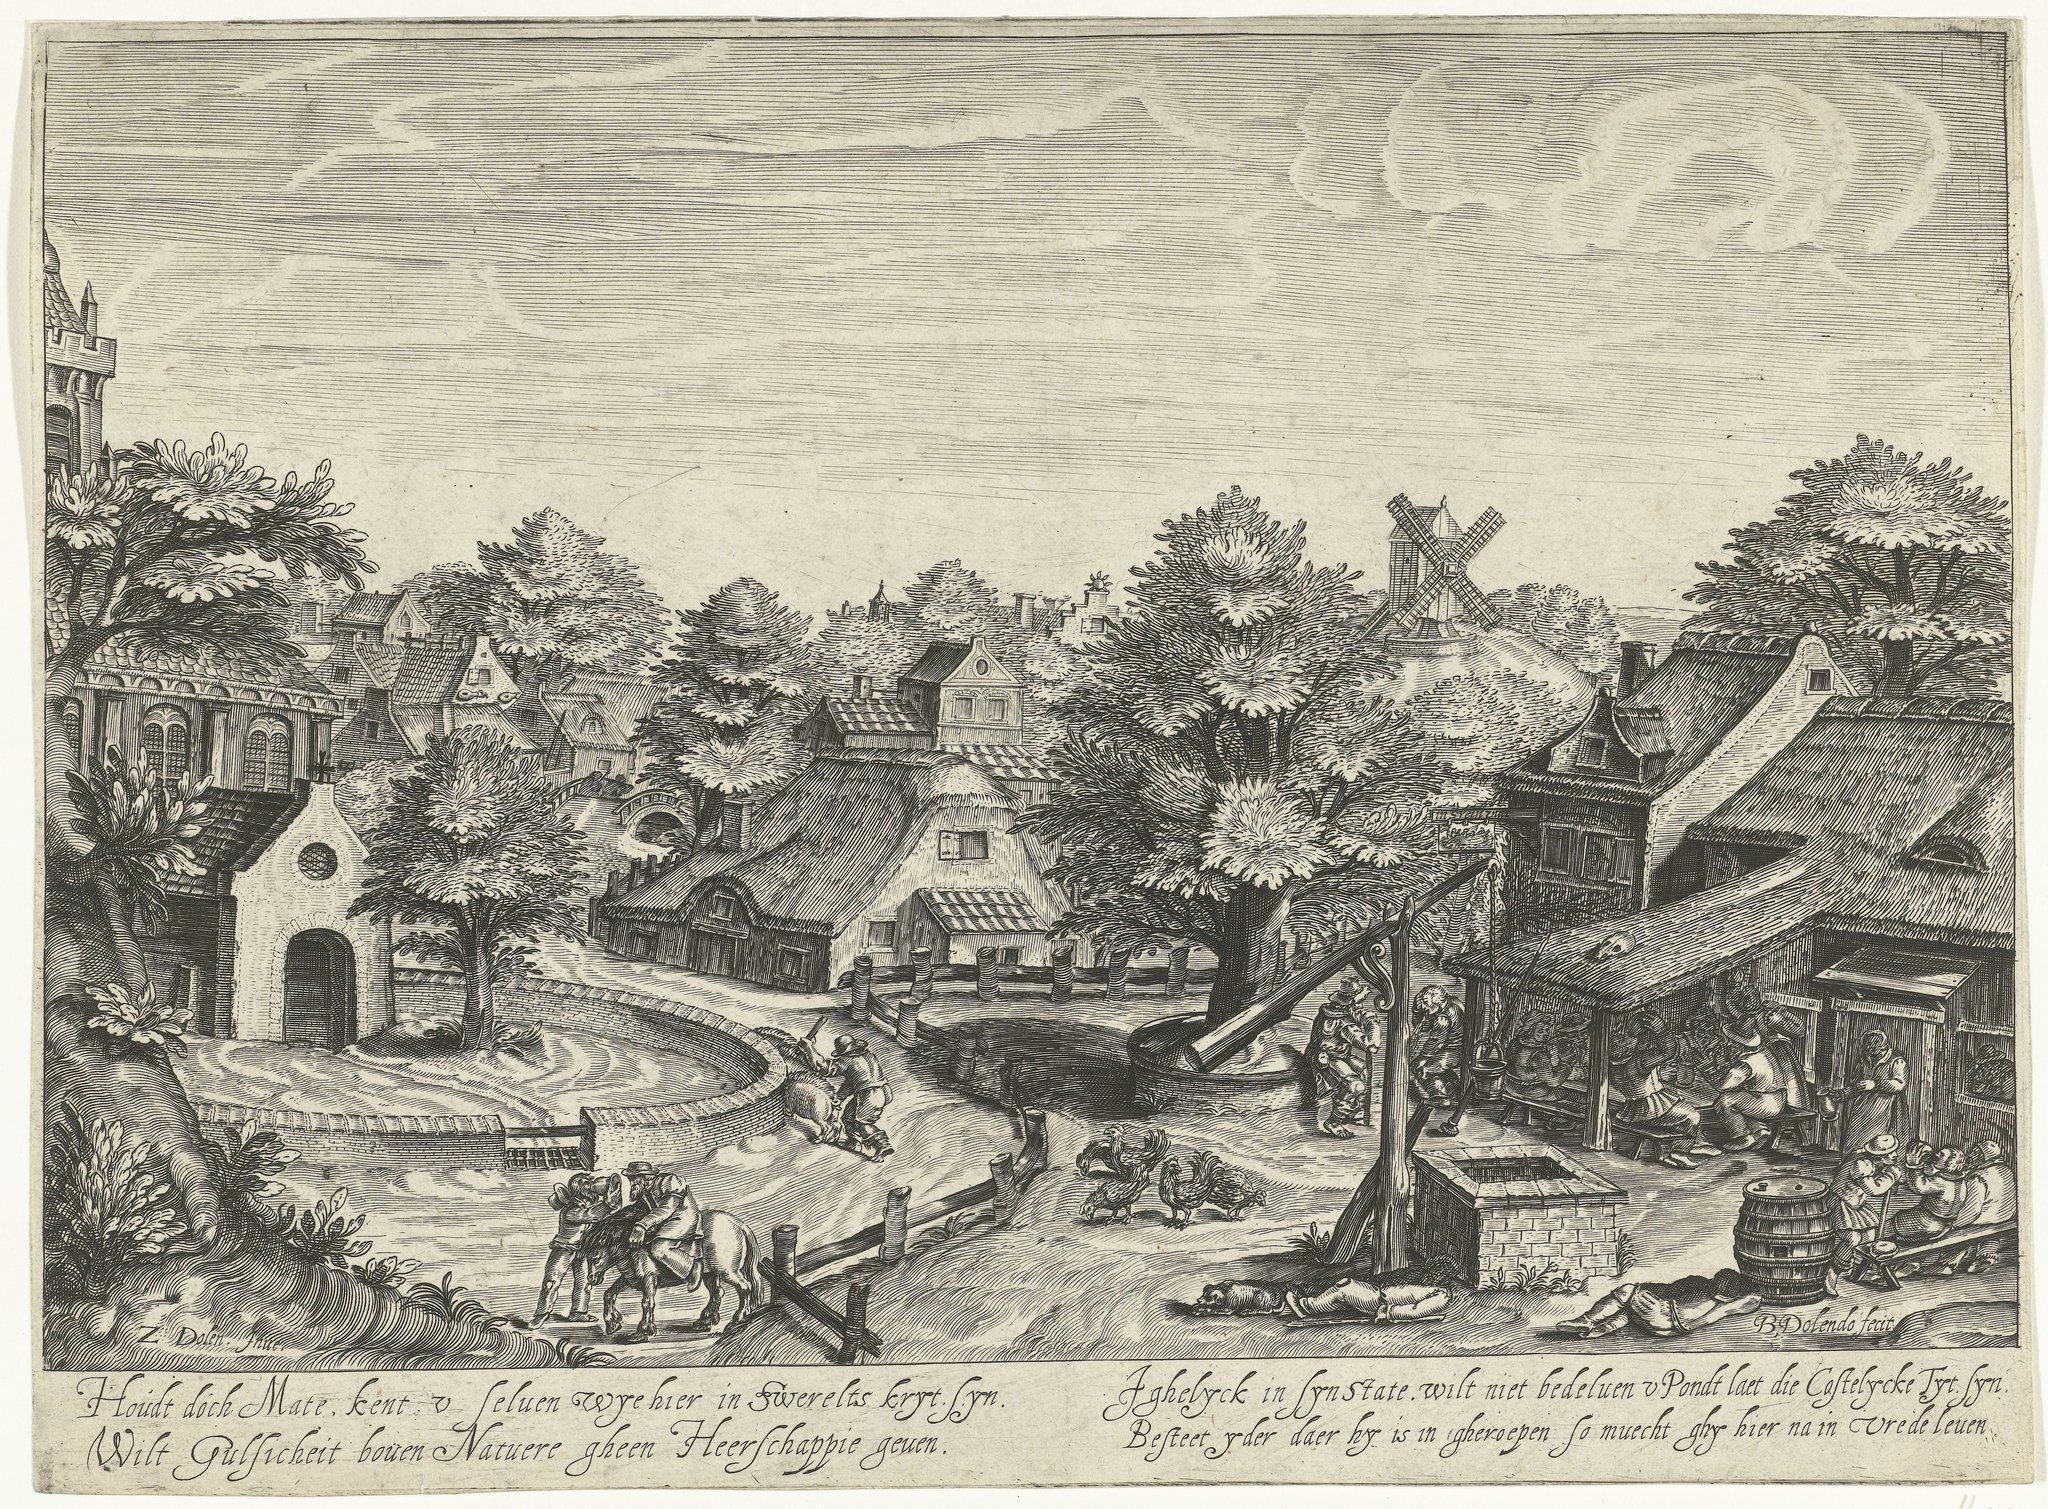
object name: print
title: Herberg met feestende gasten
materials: paper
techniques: engraving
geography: leiden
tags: temperance, teetotalism, periodic celebrations, popular feasts (+ eating and drinking ~ festive activities)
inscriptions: signature: ‘B. Dolendo fecit.’, collector's mark: Lugt 2228, caption: ‘Houdt doch Mate - in vrede leven’, signature: ‘Z: Dolen Inue.’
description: Bij een herberg zitten mensen op banken onder een afdak te feesten en te drinken. Twee mannen liggen naast een waterput op de grond en slapen hun roes uit. Langs de weg staat een reiziger met paard te praten met een van de feestgangers die uit een bierpul drinkt. De herberg ligt aan de rand van een stad naast de kerk. Onder de voorstelling een Nederlands vers over matigheid.